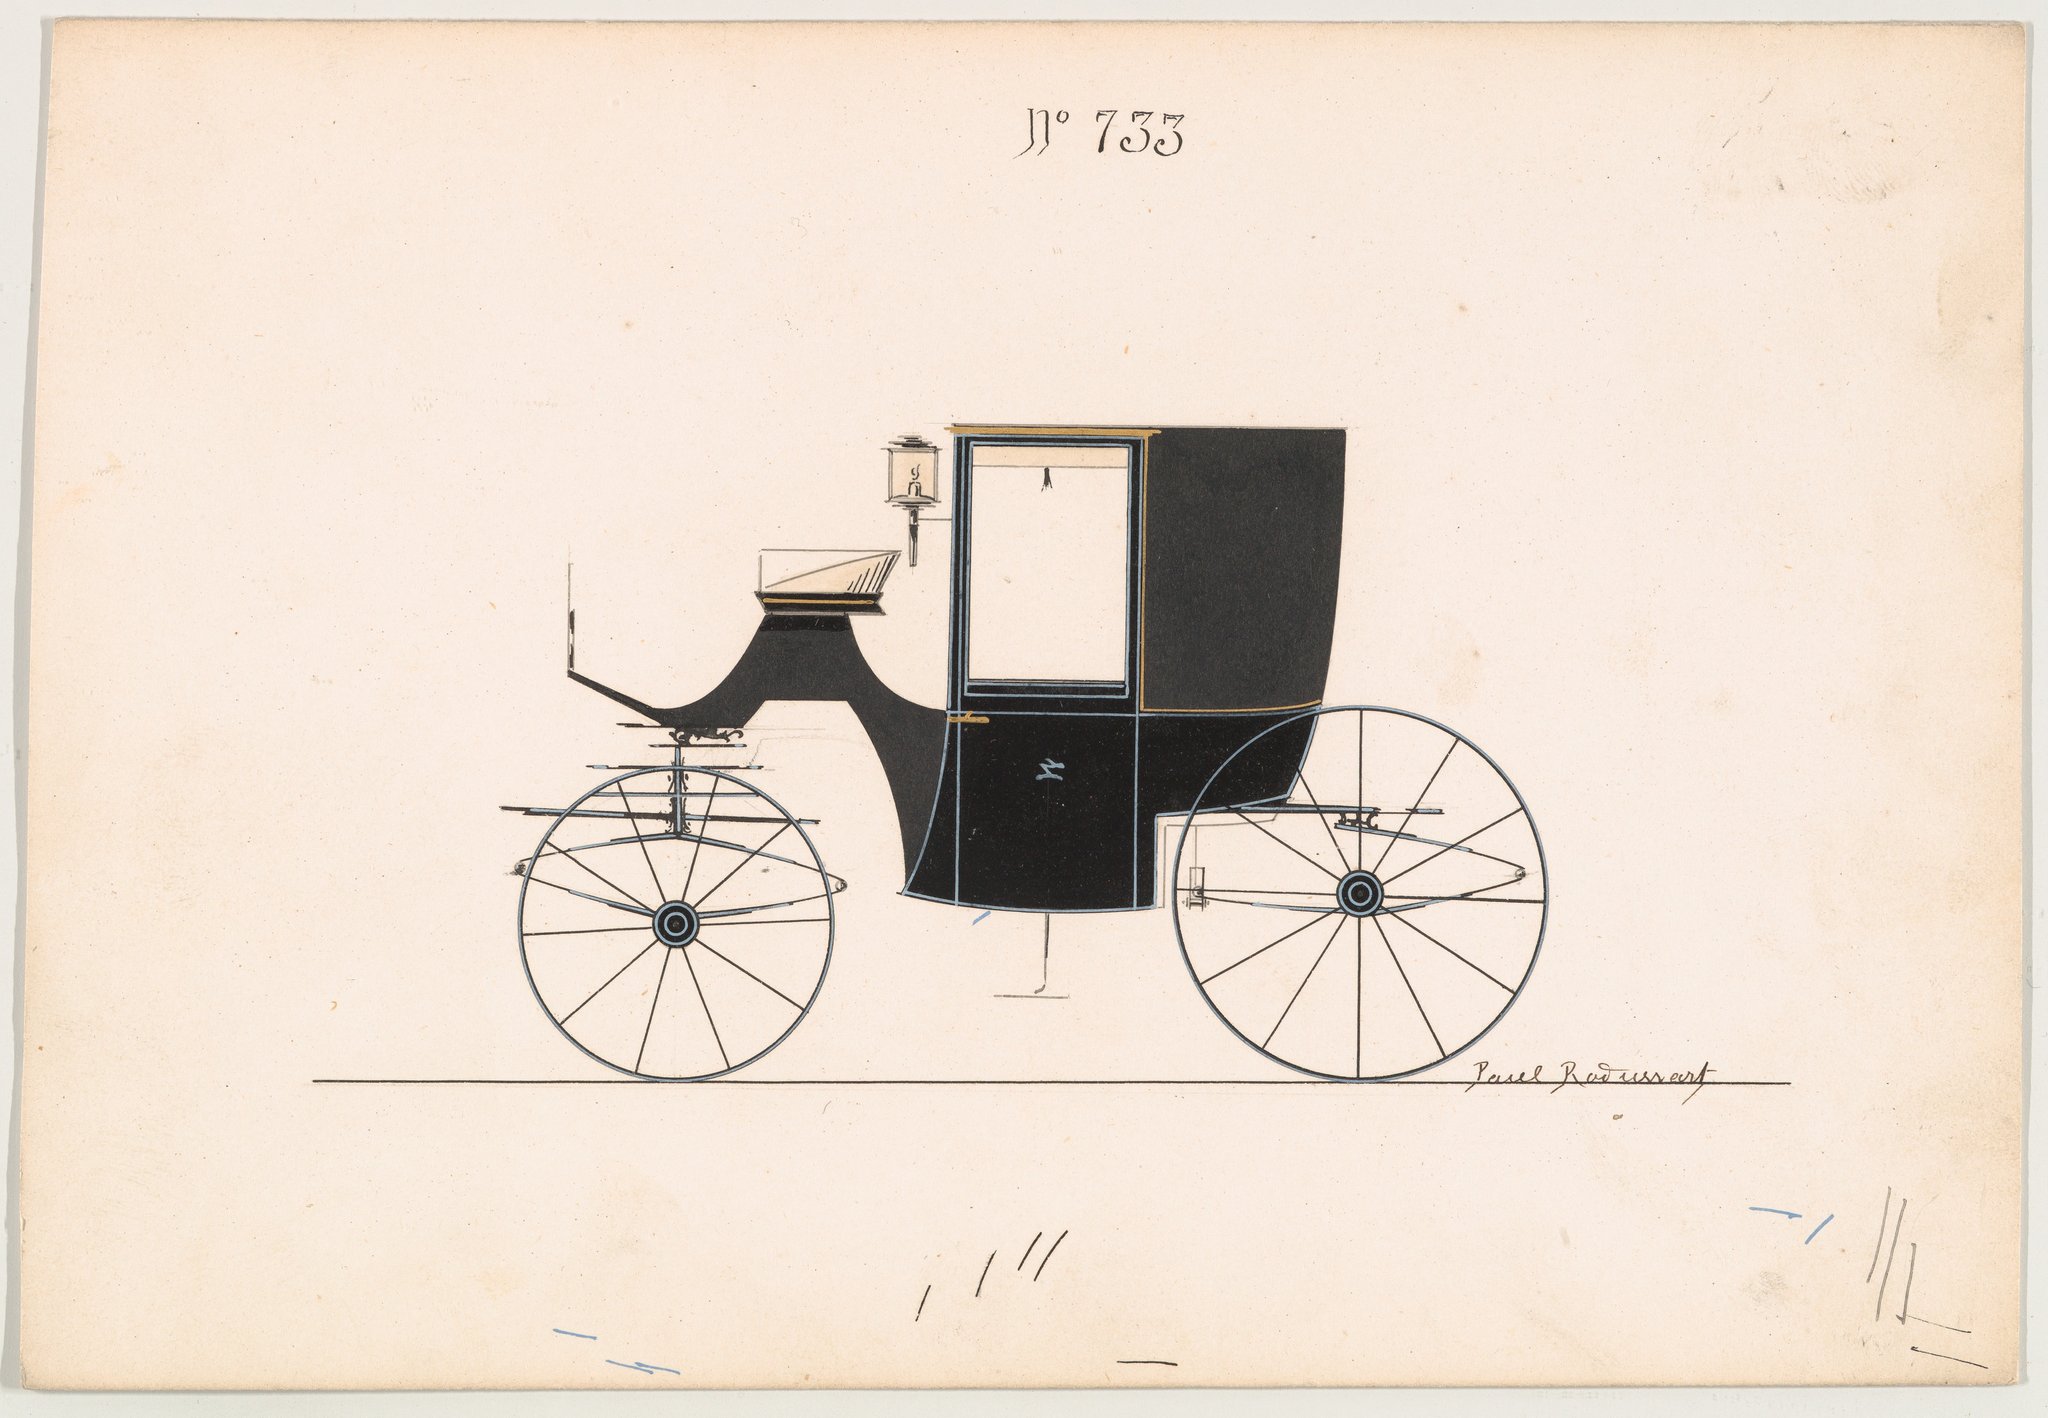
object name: drawing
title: Coupe #733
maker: brewster & co.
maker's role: manufacturer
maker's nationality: american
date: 1860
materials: gouache, gum arabic, ink, watercolor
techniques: pen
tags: carriages